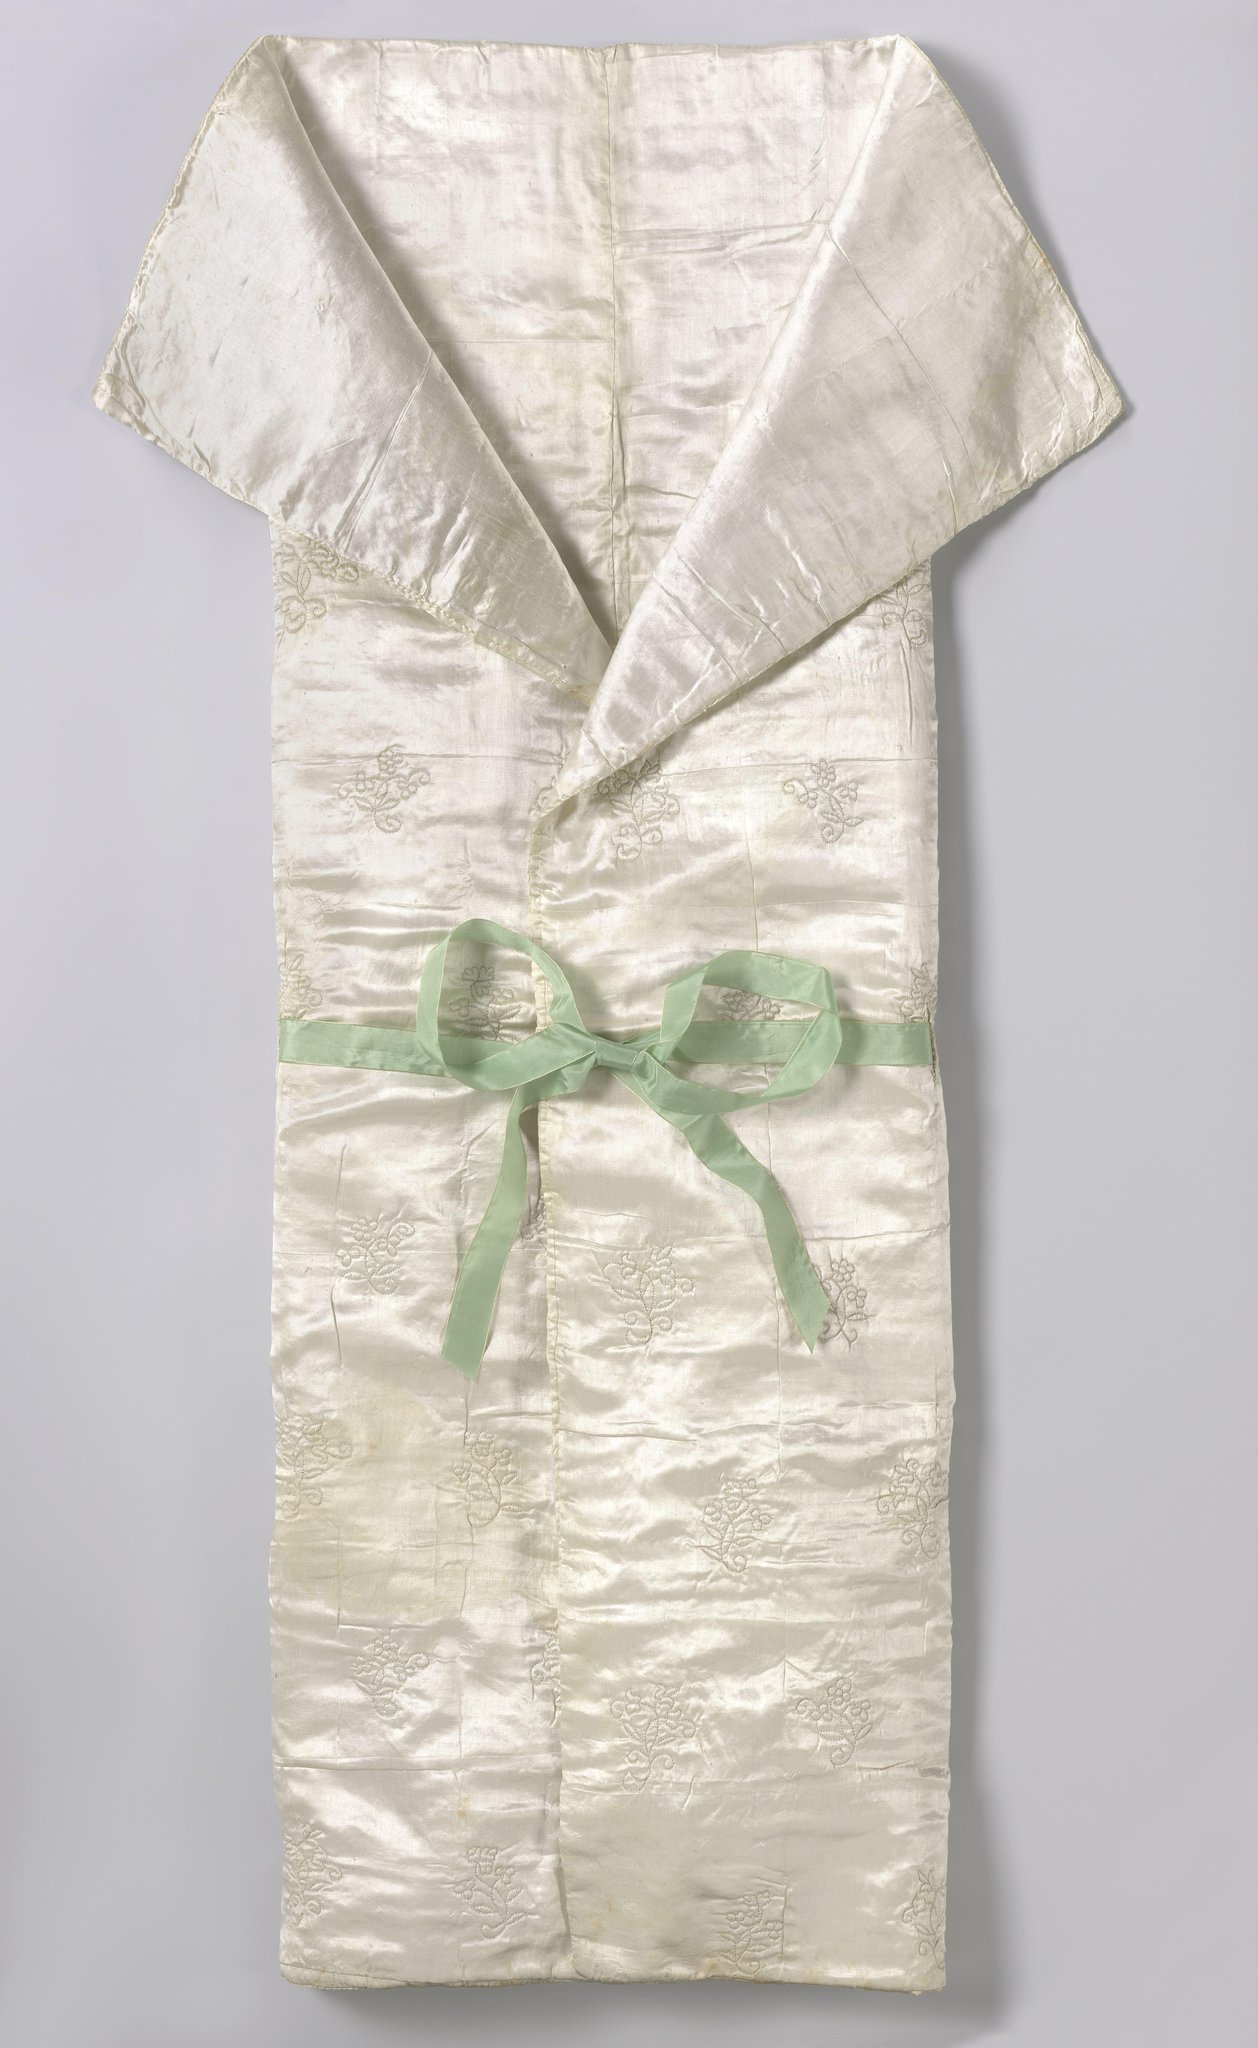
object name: doopluur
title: Doopluur van zijde geborduurd met floraal strooimotief, gewatteerd met geweven wol en gevoerd met effen zijde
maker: Anonymous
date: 1675-1700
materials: silk, wool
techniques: embroidered, stitching, weave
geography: northern netherlands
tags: netherlands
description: Doopluur van zijde geborduurd met floraal strooimotief, gewatteerd met geweven wol en gevoerd met effen zijde. Model: rechthoekig om met een overslag dicht te vouwen en voorzien van twee gefestonneerde splitten waar een lint ter sluiting doorheen getrokken werd. . Versiering: de effen buitenkant is versierd met een verspringend strooimotief van twee afwendende bloemen gestikt. Het quilt- of stikwerk is alleen door de zijden buitenkant en de geweven wollen vulling gestoken. De voering is geheel onversierd. Het oorspronkelijke lint ontbreekt.